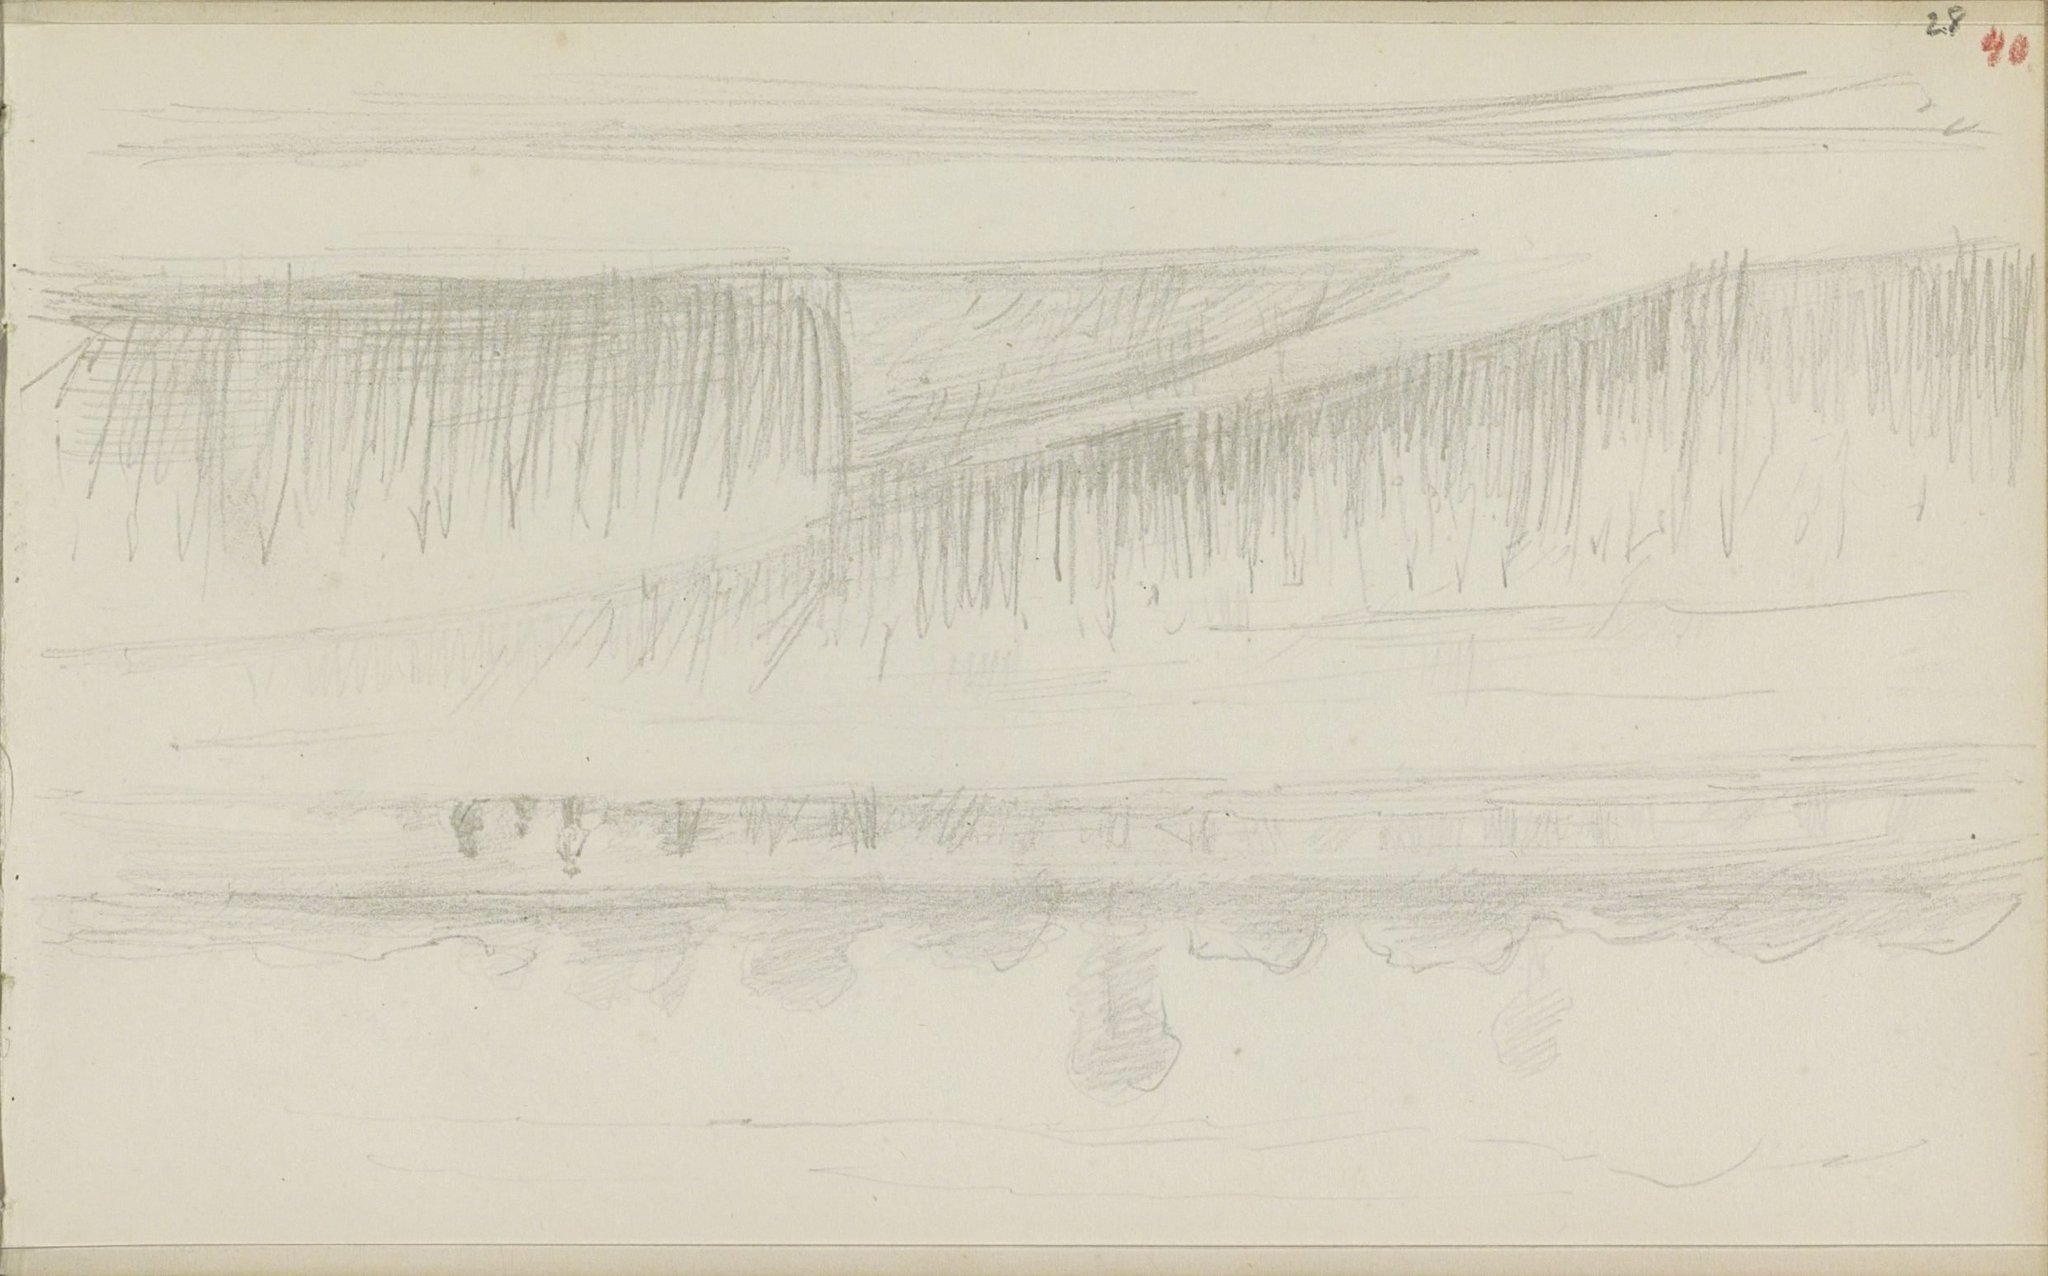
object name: sketchbook leaf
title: Figuren in een weiland omgrensd door een sloot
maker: jozef israëls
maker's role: draughtsman, painter, print maker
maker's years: 1824-1911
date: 1834-1911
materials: paper, pencil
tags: landscapes with waters, waterscapes, seascapes (in the temperate zone) (+ landscape with figures, staffage), small canal, ditch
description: Blad 28 recto uit een schetsboek met 37 bladen.